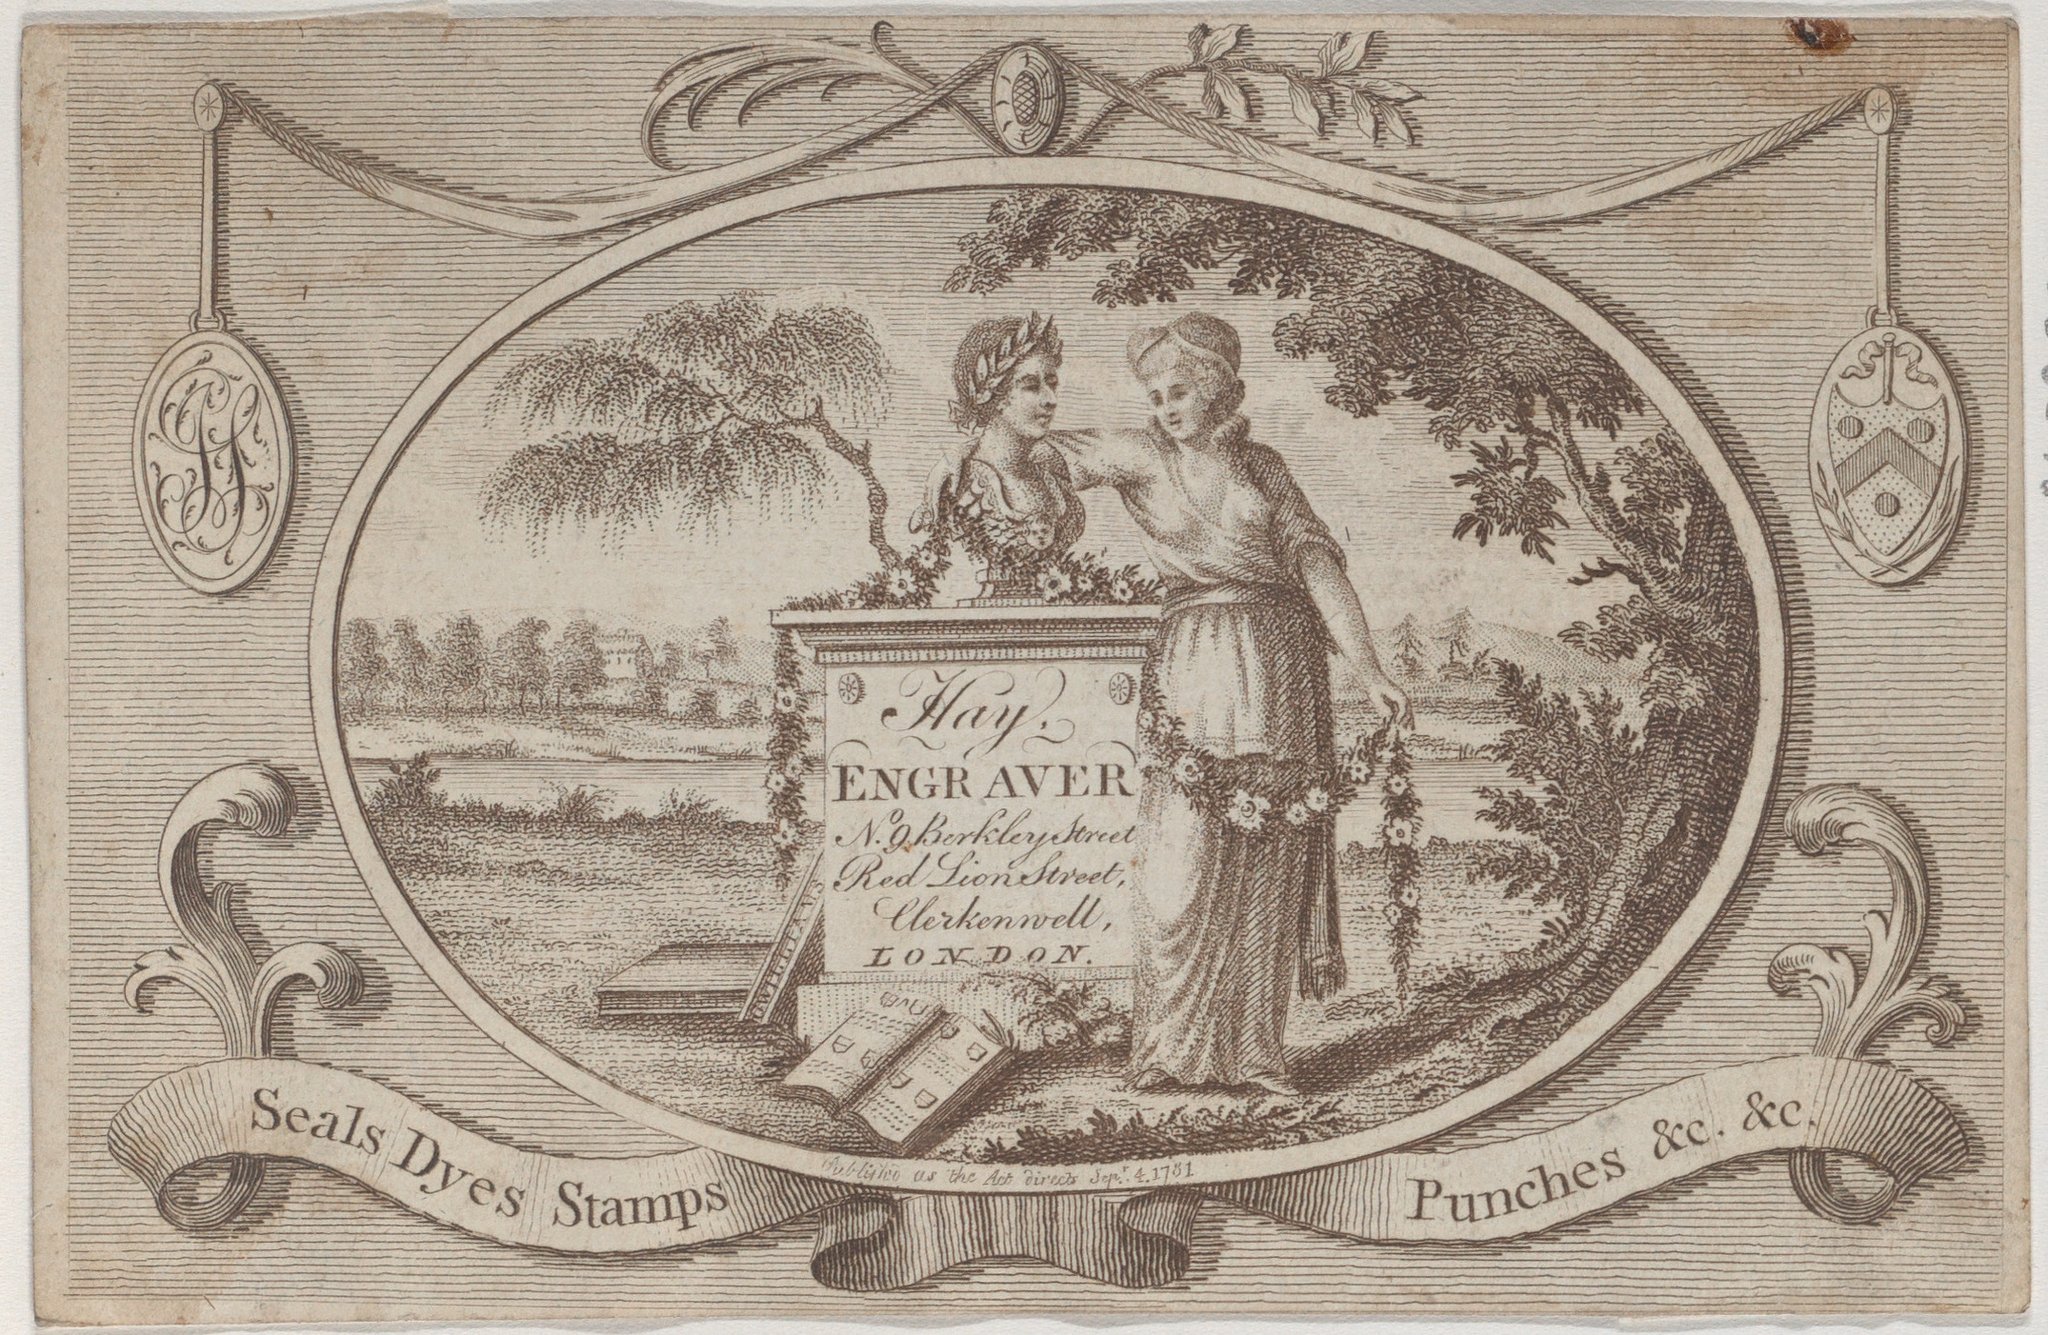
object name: print, trade card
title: Book Label for Hay, Engraver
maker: anonymous, british, 18th century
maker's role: artist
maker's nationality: british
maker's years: 1700-1800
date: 1801-1900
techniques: engraving